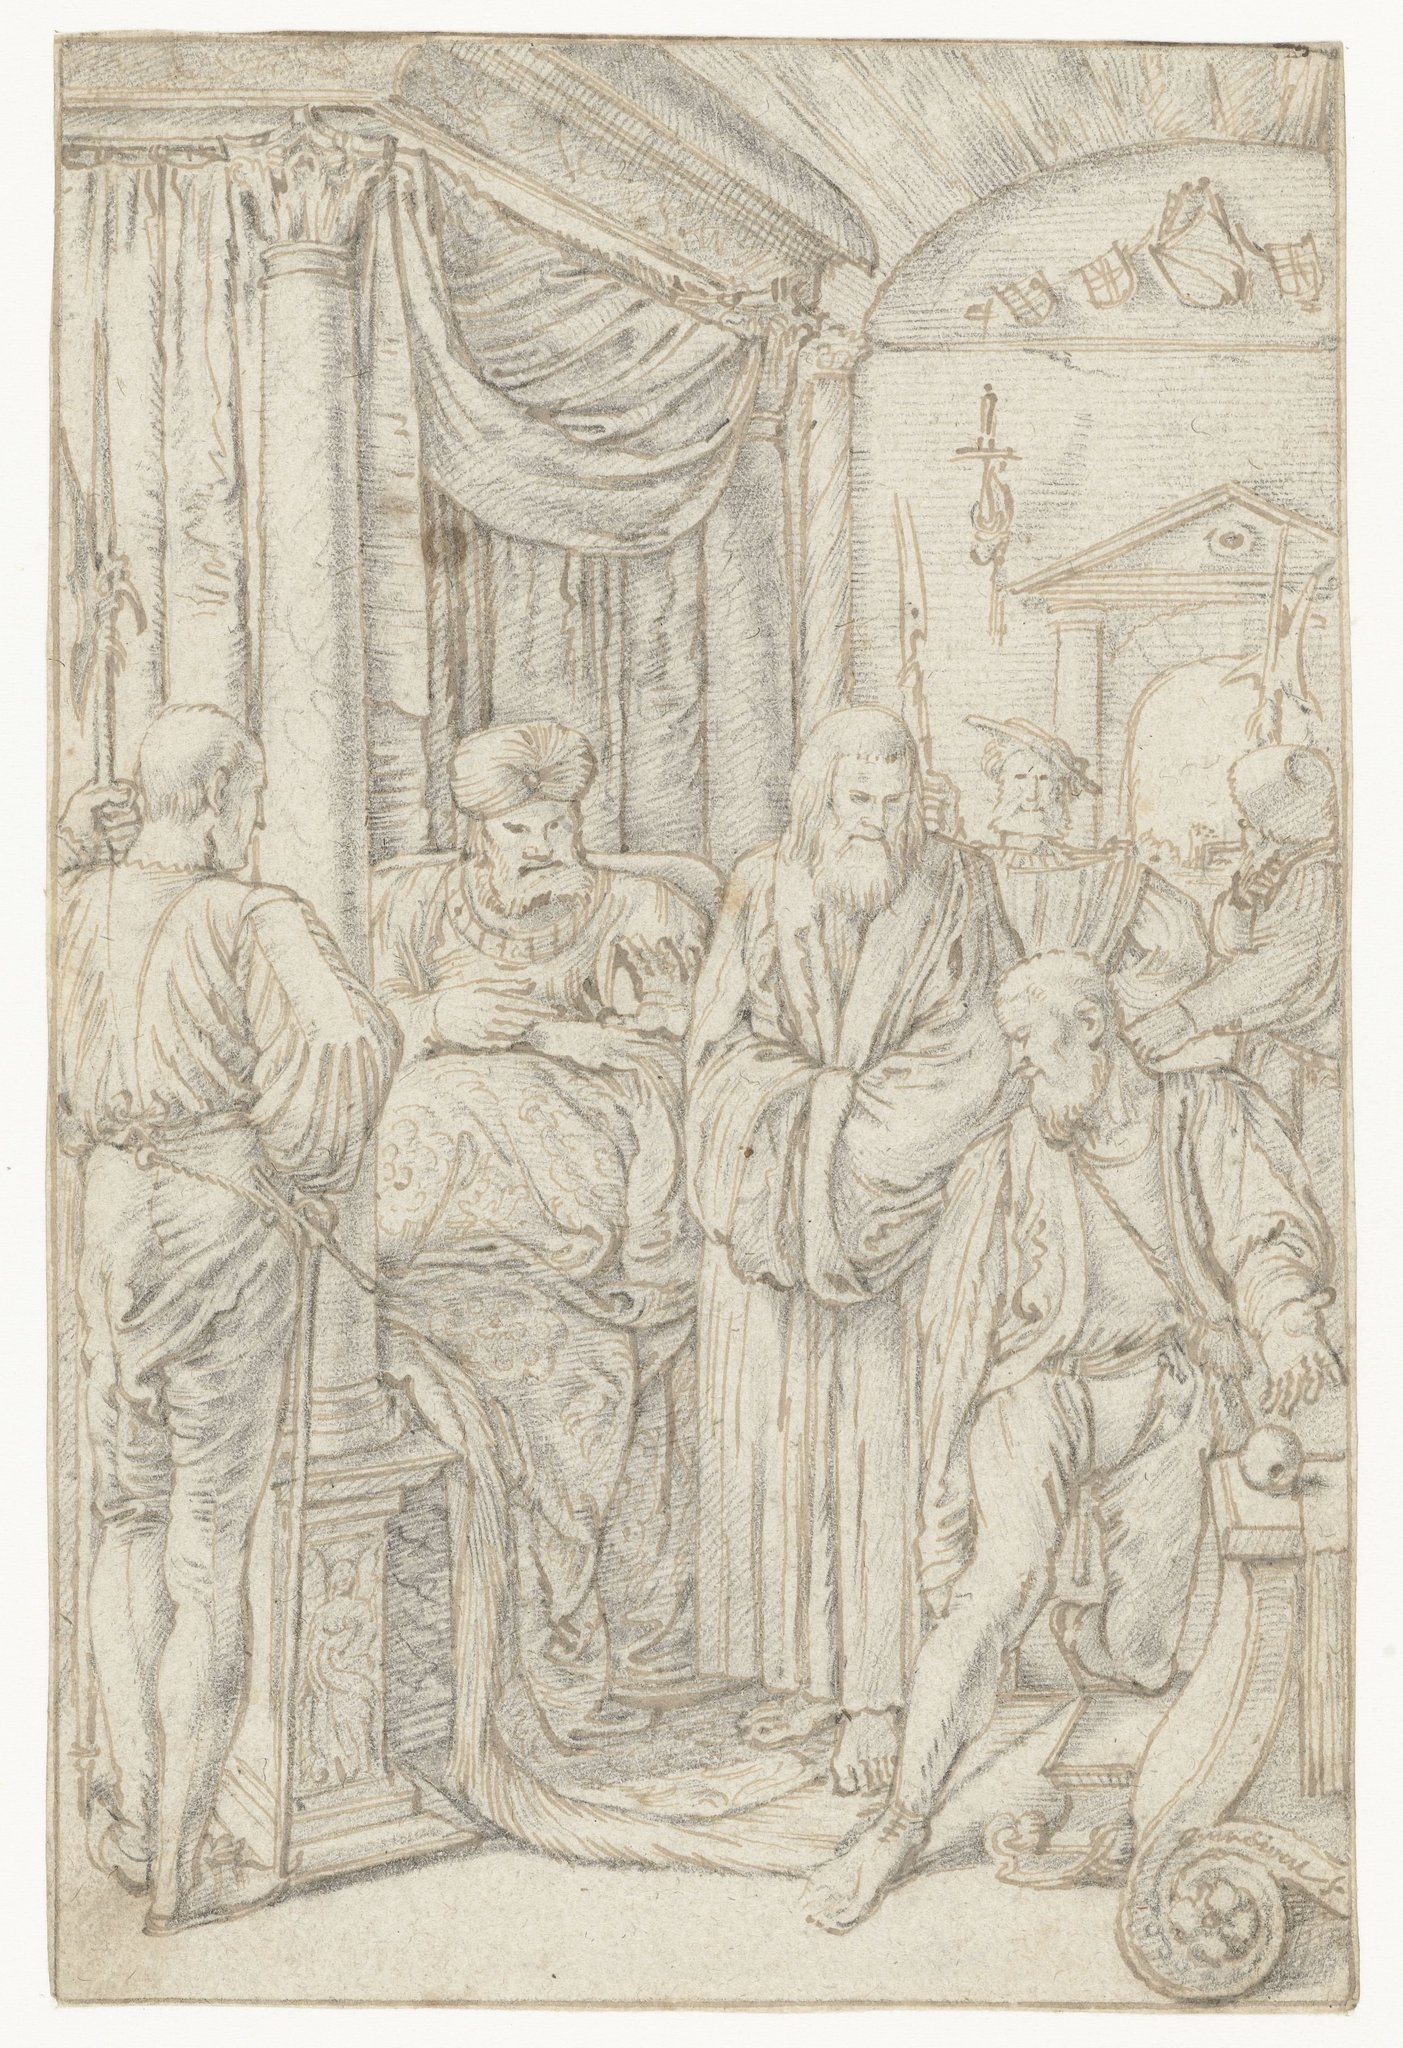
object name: drawing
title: Boer doet zijn beklag bij de graaf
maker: willem pietersz buytewech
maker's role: draughtsman, print maker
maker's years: 1592-1624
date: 1619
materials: chalk, ink, paper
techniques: pen